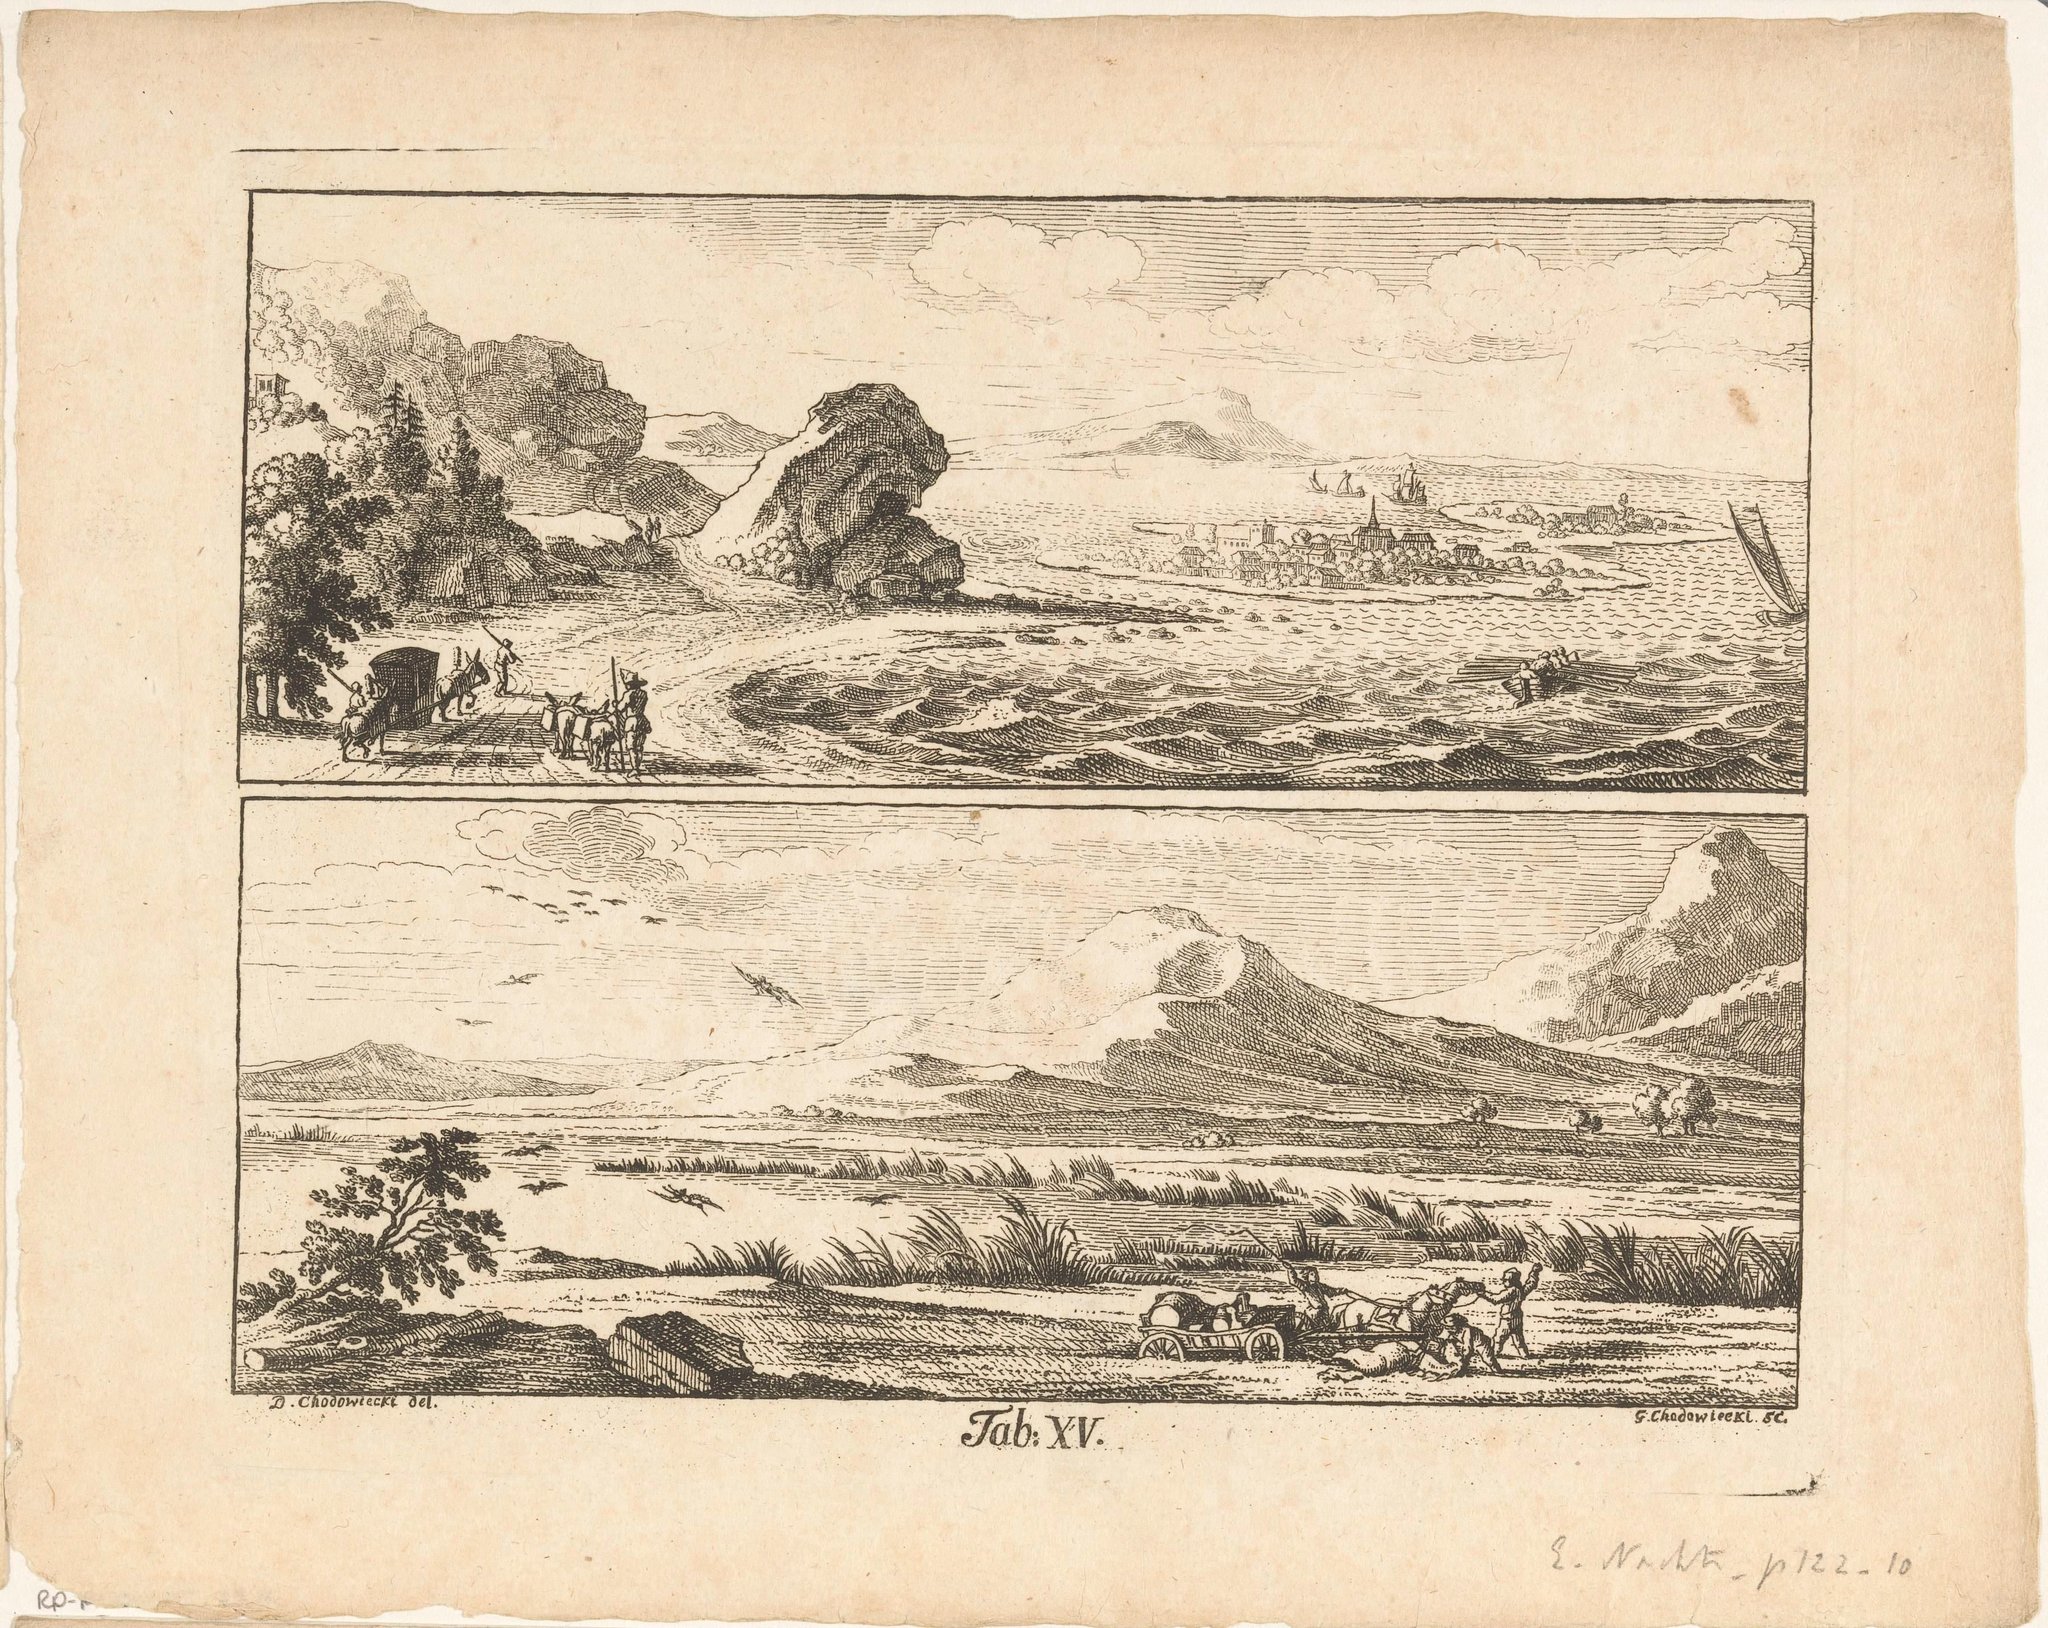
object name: print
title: Twee landschappen die verschillende delen van de aarde voorstellen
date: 1774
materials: paper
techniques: etching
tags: accident with four-wheeled, animal-drawn vehicle, e.g.: cab, carriage, coach, island, landscapes, traffic on land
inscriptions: collector's mark: Lugt 2228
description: Prent uit: Basedow, Johann Bernhard. Kupfersammlung zu J.B. Basedows Elementarwerke für die Jugend und ihre Freunde (...). Berlijn en Dessau: s.n., 1774.